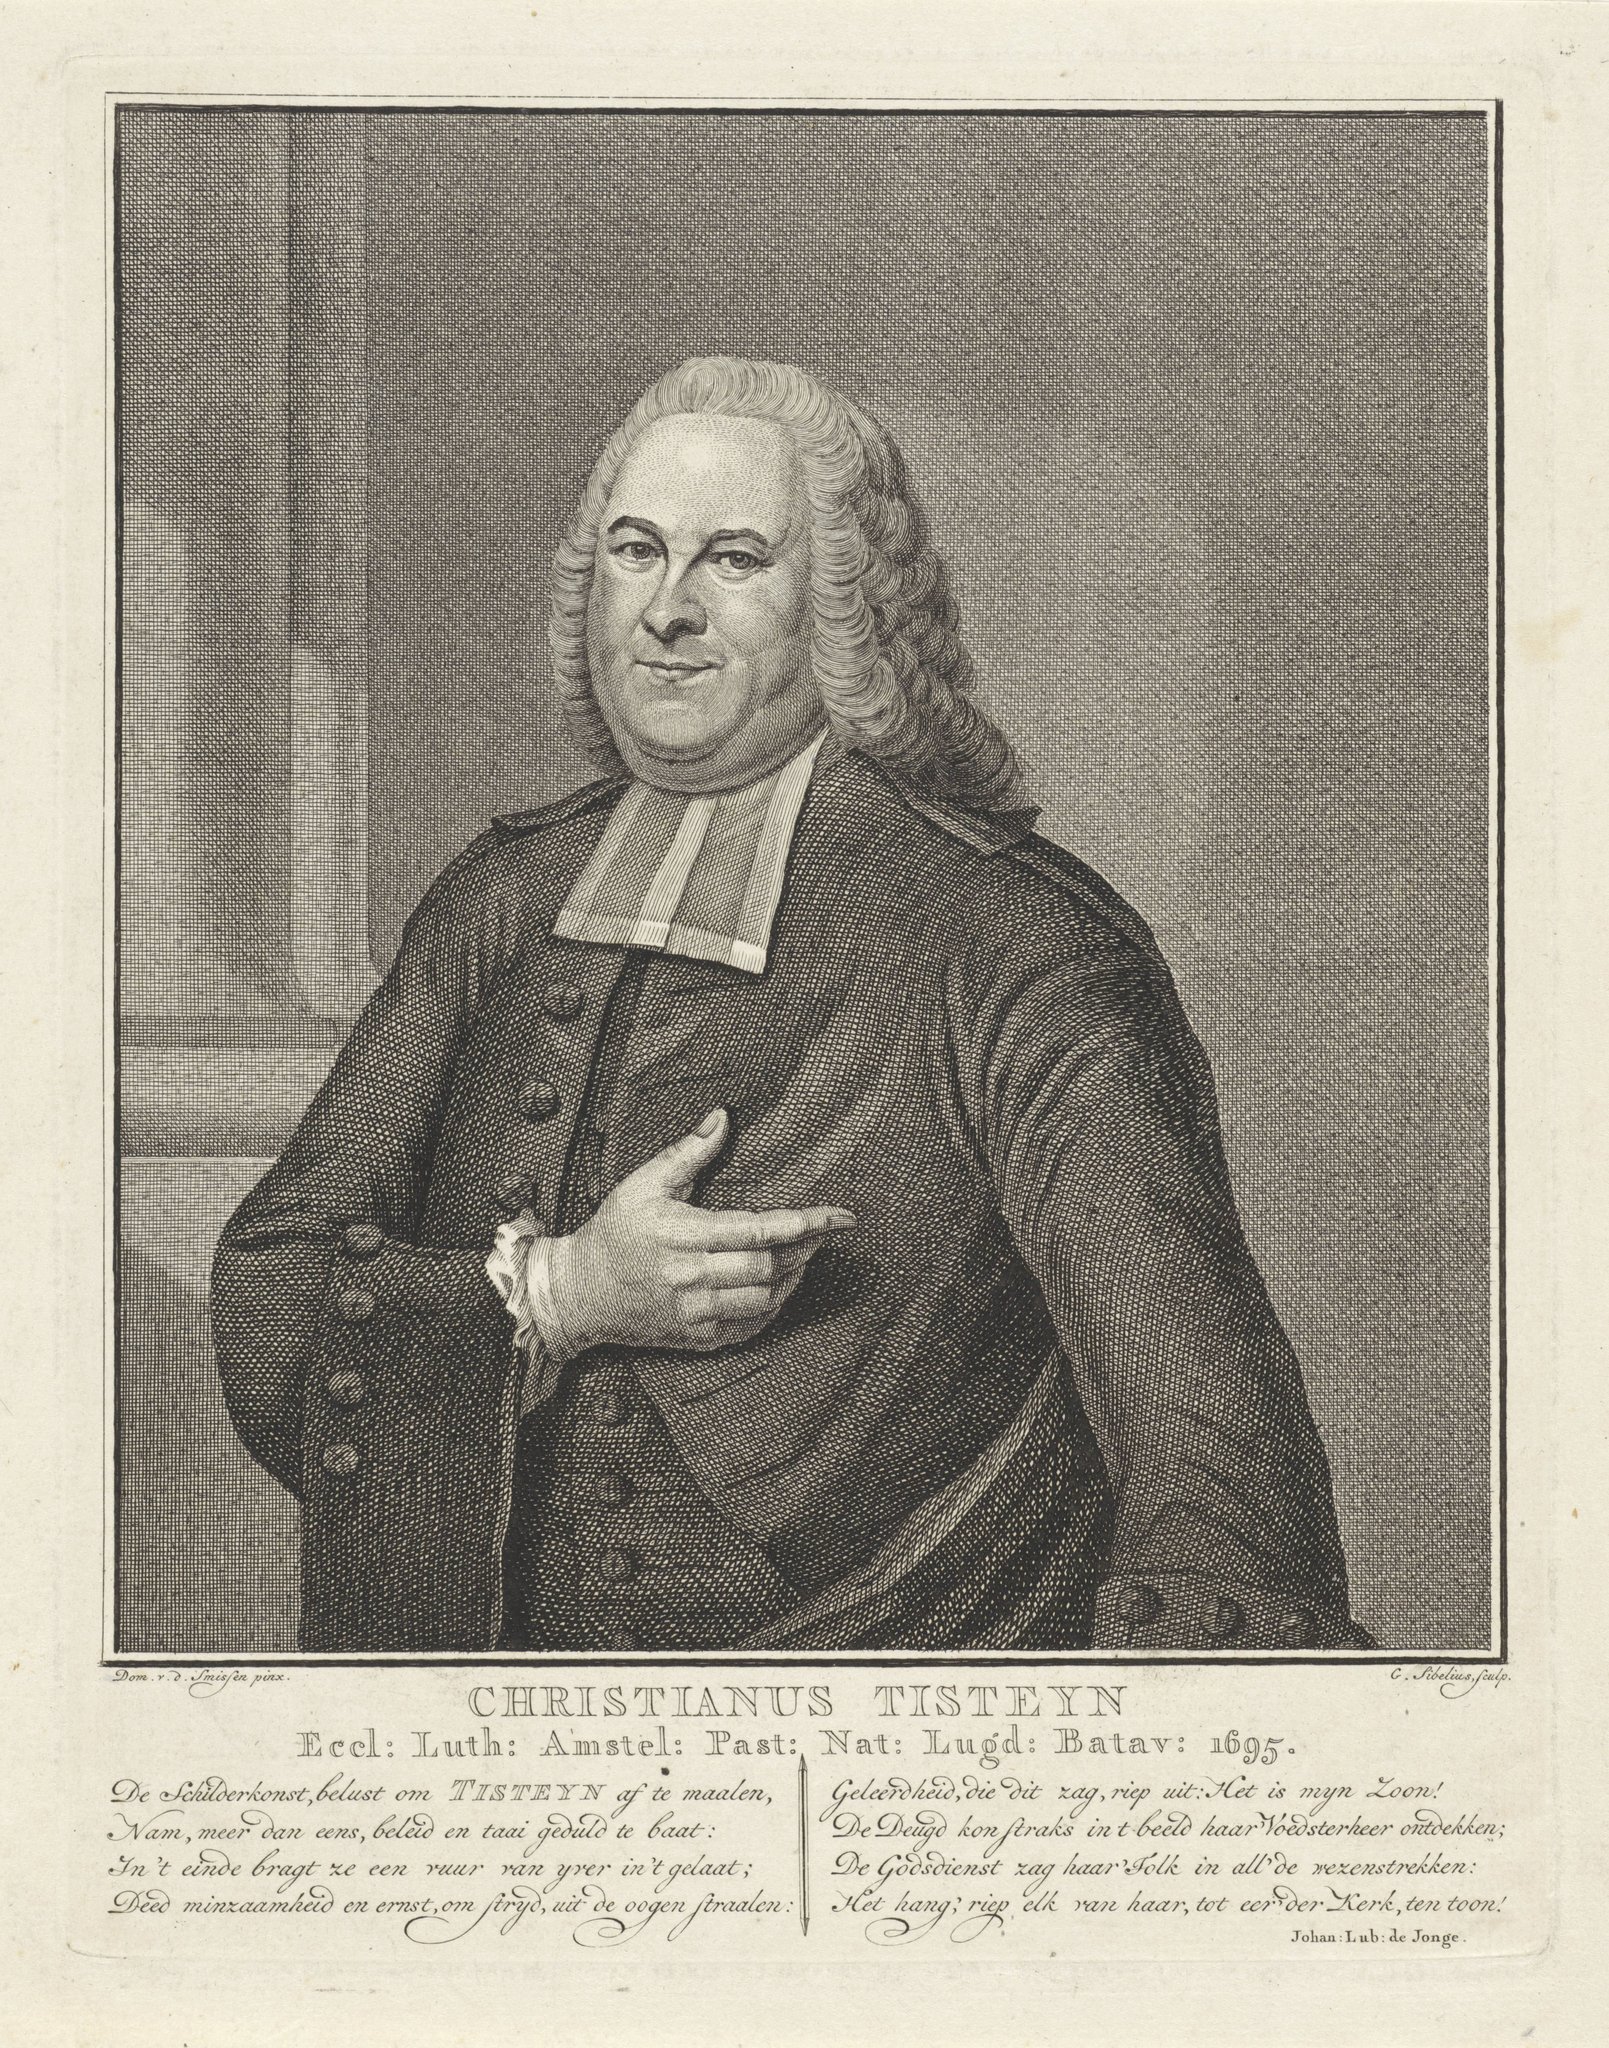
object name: print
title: Portret van Christiaan Tisteijn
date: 1755-1785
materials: paper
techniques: engraving, etching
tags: leiden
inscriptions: collector's mark: Lugt 2228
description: Portret van de Amsterdamse predikant Christiaan Tisteijn. Onder het portret zijn naam, fuchtie en geboortejaar en -plaats. Daaronder een lofdicht in het Nederlands.